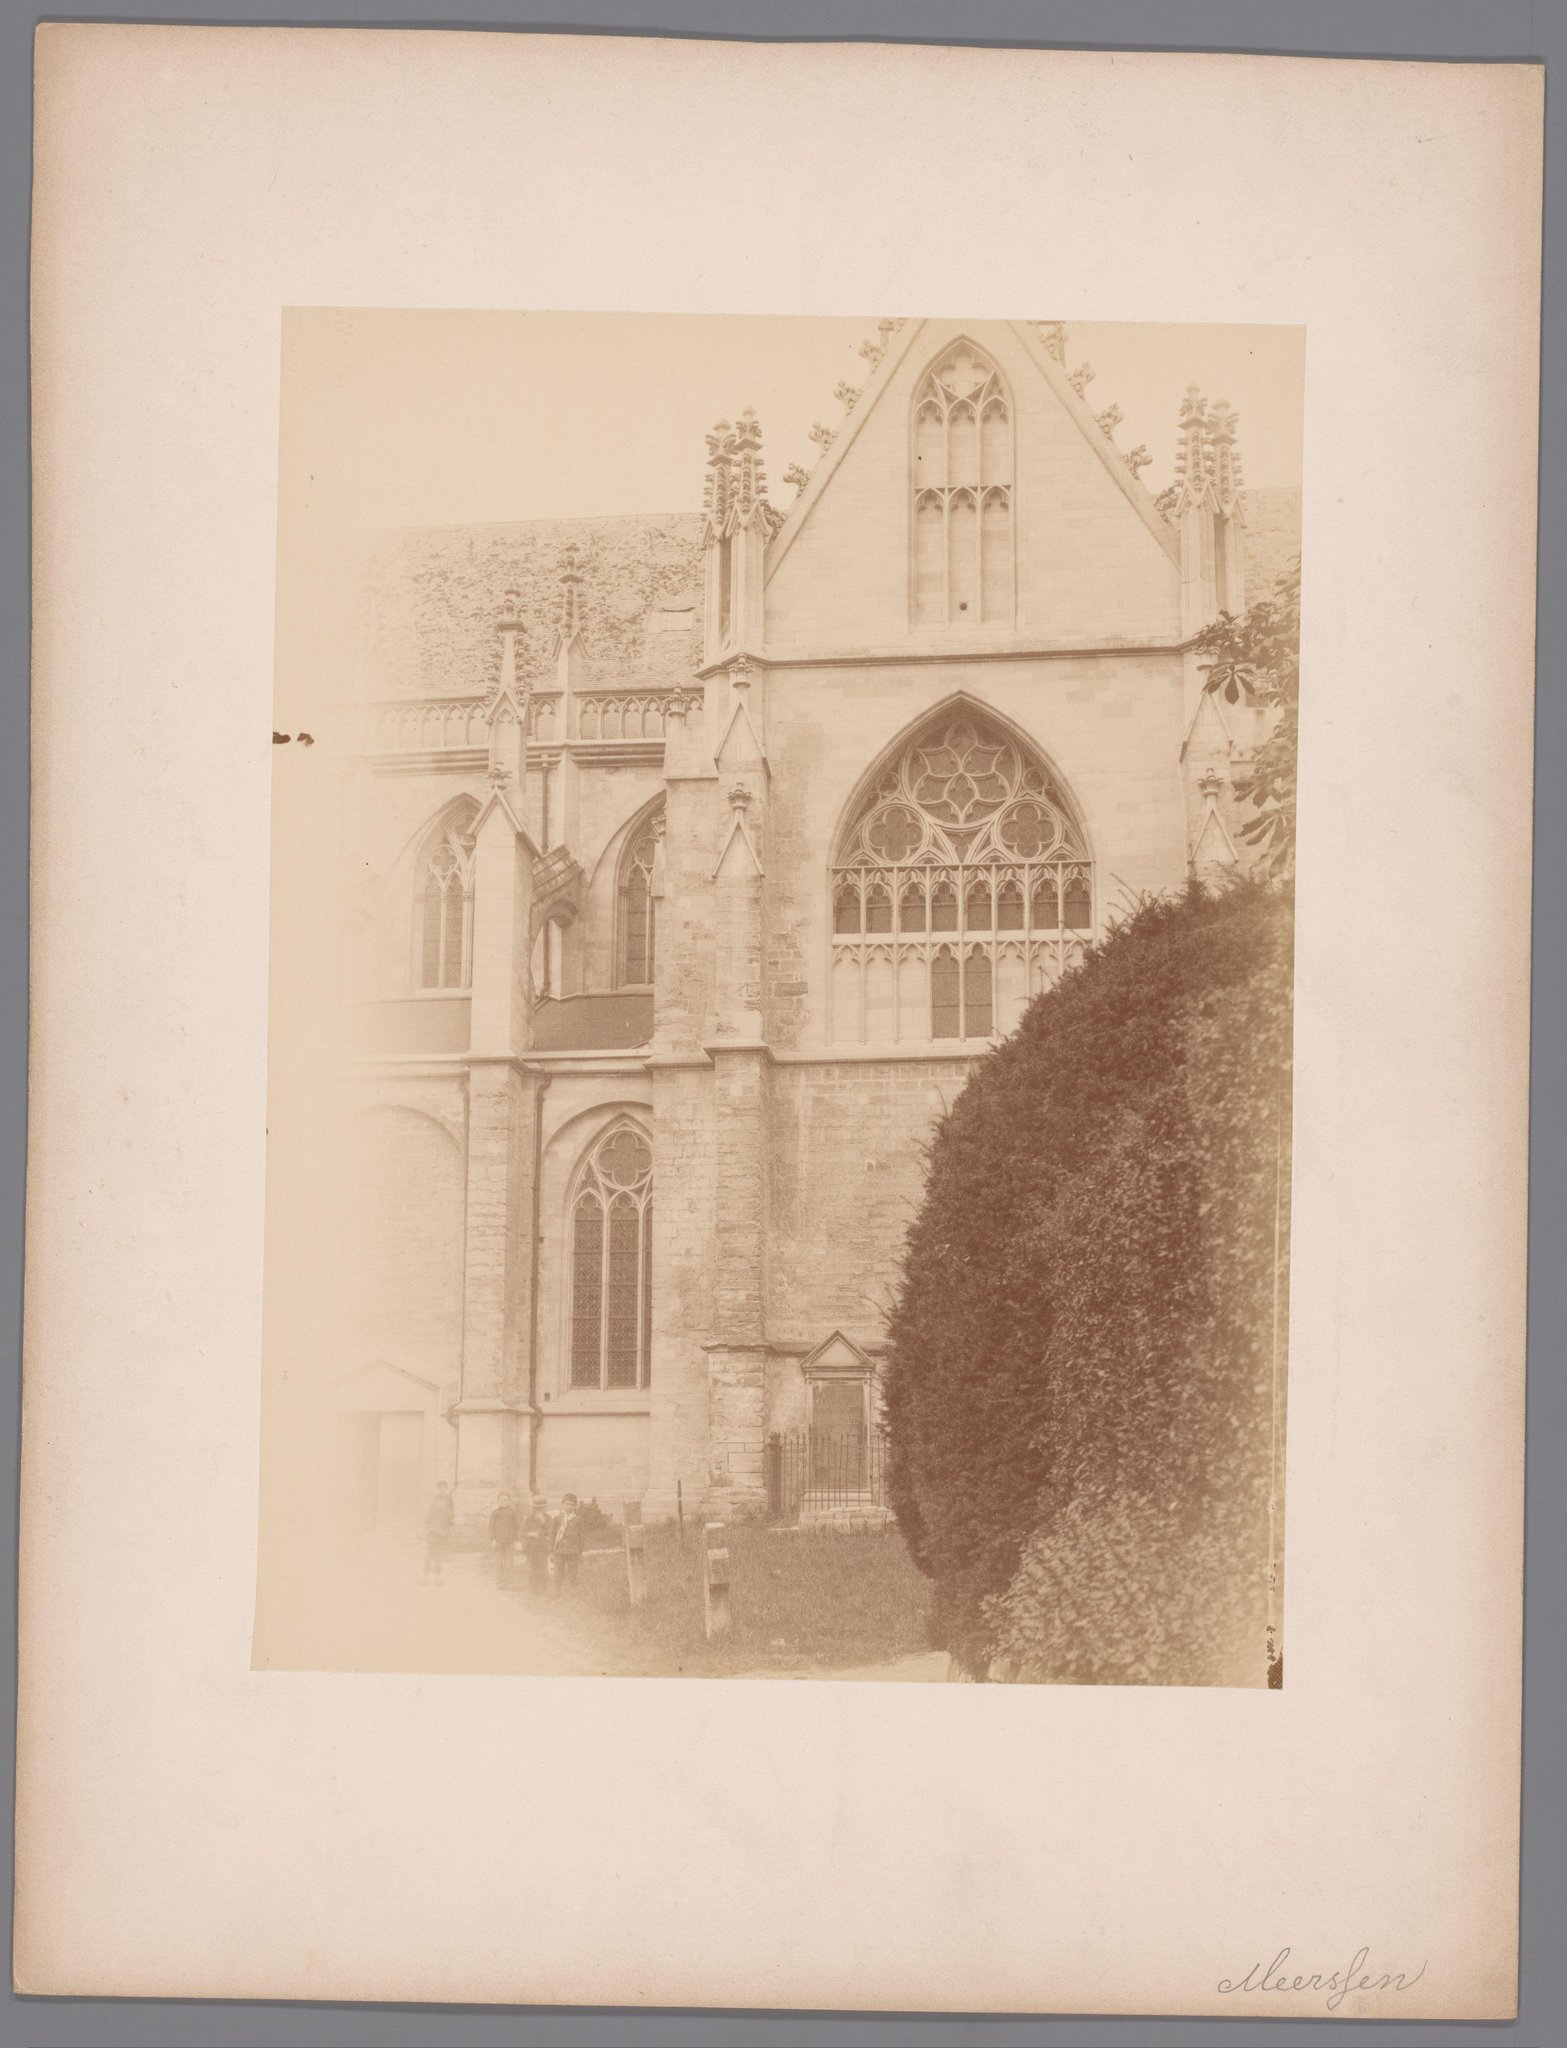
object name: photograph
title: Zuidzijde van de Sint-Bartholomeusbasiliek te Meerssen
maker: anoniem (monumentenzorg)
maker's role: fotograaf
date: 1890-1920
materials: cardboard, photographic support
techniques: albumen print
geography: meerssen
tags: church (exterior)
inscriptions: annotation: ‘Meerssen’, annotation: ‘Meerssen/ Zuidtzijde kerk’